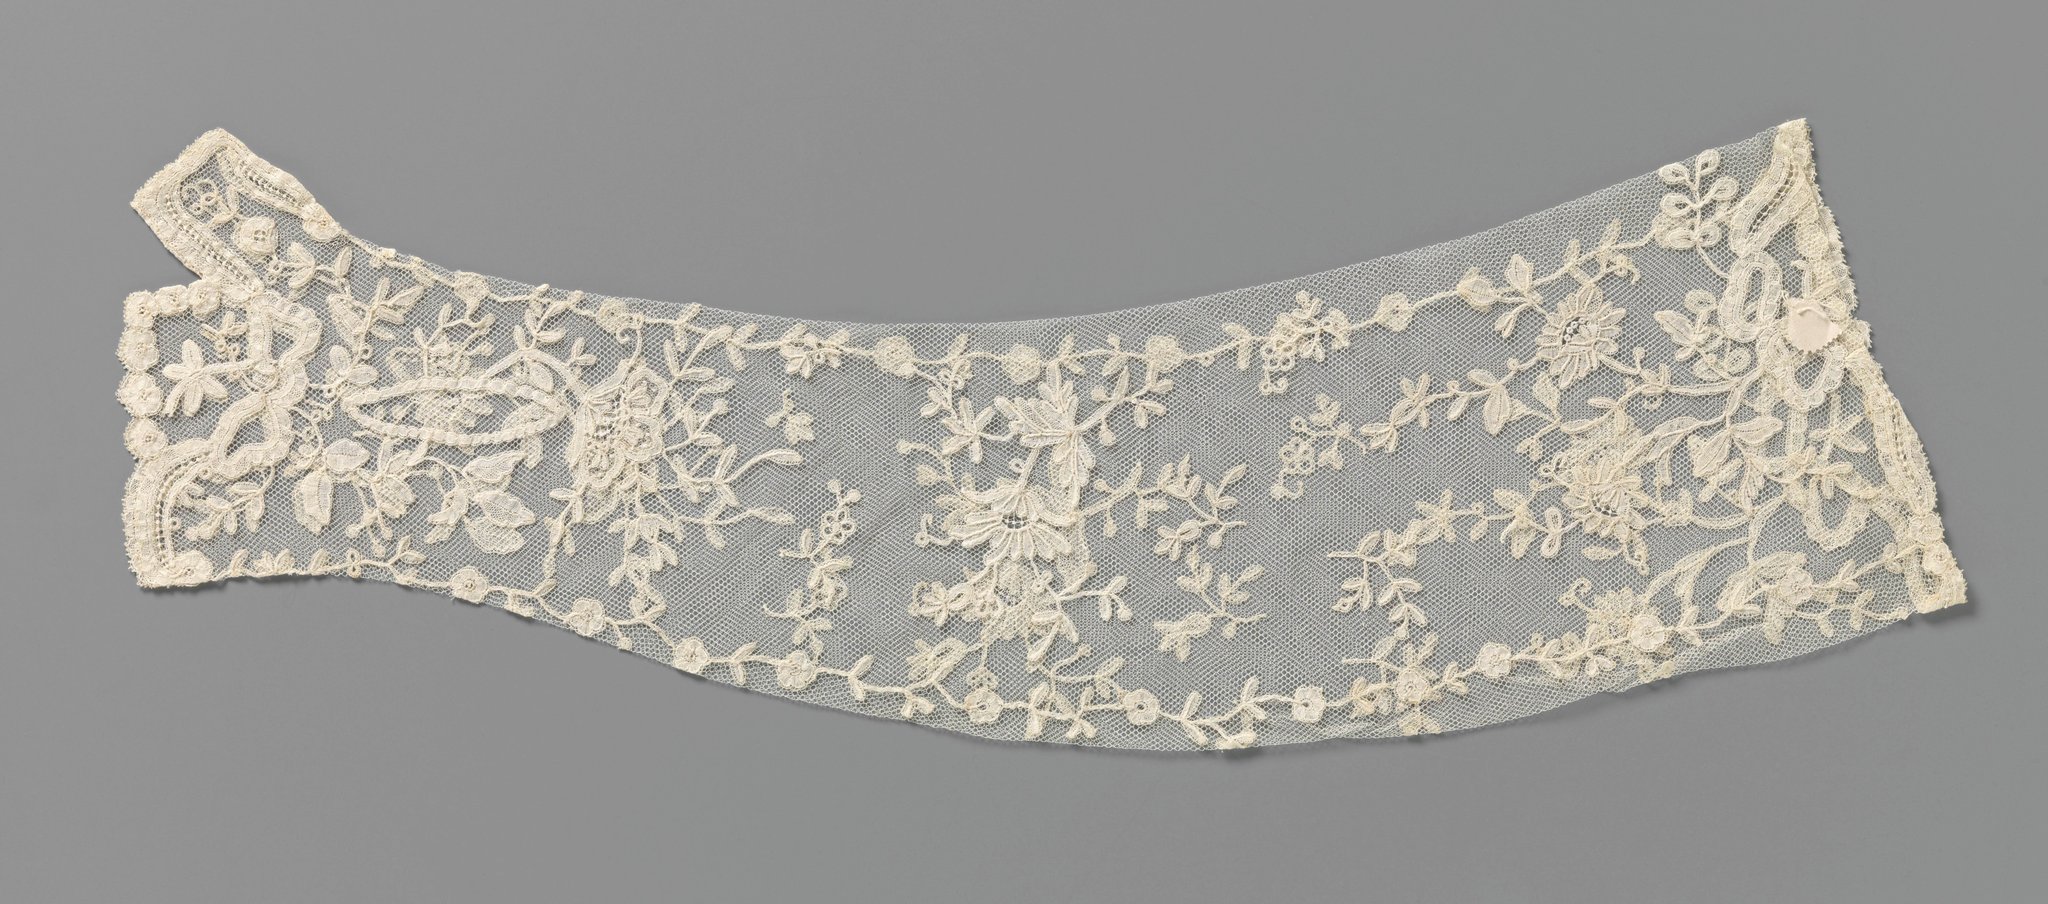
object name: mitt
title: Mitaine van applicatiekant met rozen en margrieten en strikken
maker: Anonymous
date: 1900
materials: linen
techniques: lace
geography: brussels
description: Mitaine van naturelkleurige Brusselse applicatiekant: kloskant met naaldkantsiersteken geappliceerd op machinale tule. Het model is als rond geknipte mouwen, hol van binnen en bol van buiten. Het patroon is aan beide zijden gelijk en heeft margrieten en andere bloemen met een strik bijeengebonden. In het midden heeft het een los boeket bloemen en gestrooide rozeknoppen, omlijst door een ijle slinger met rozen. De motieven zijn gemaakt in netslag en linnenslag met opengewerkte randjes en op verschillende plekken geaccentueerd door reliëfcontourlijnen. In bloemharten en linten zijn naaldkantsiersteken toegepast.